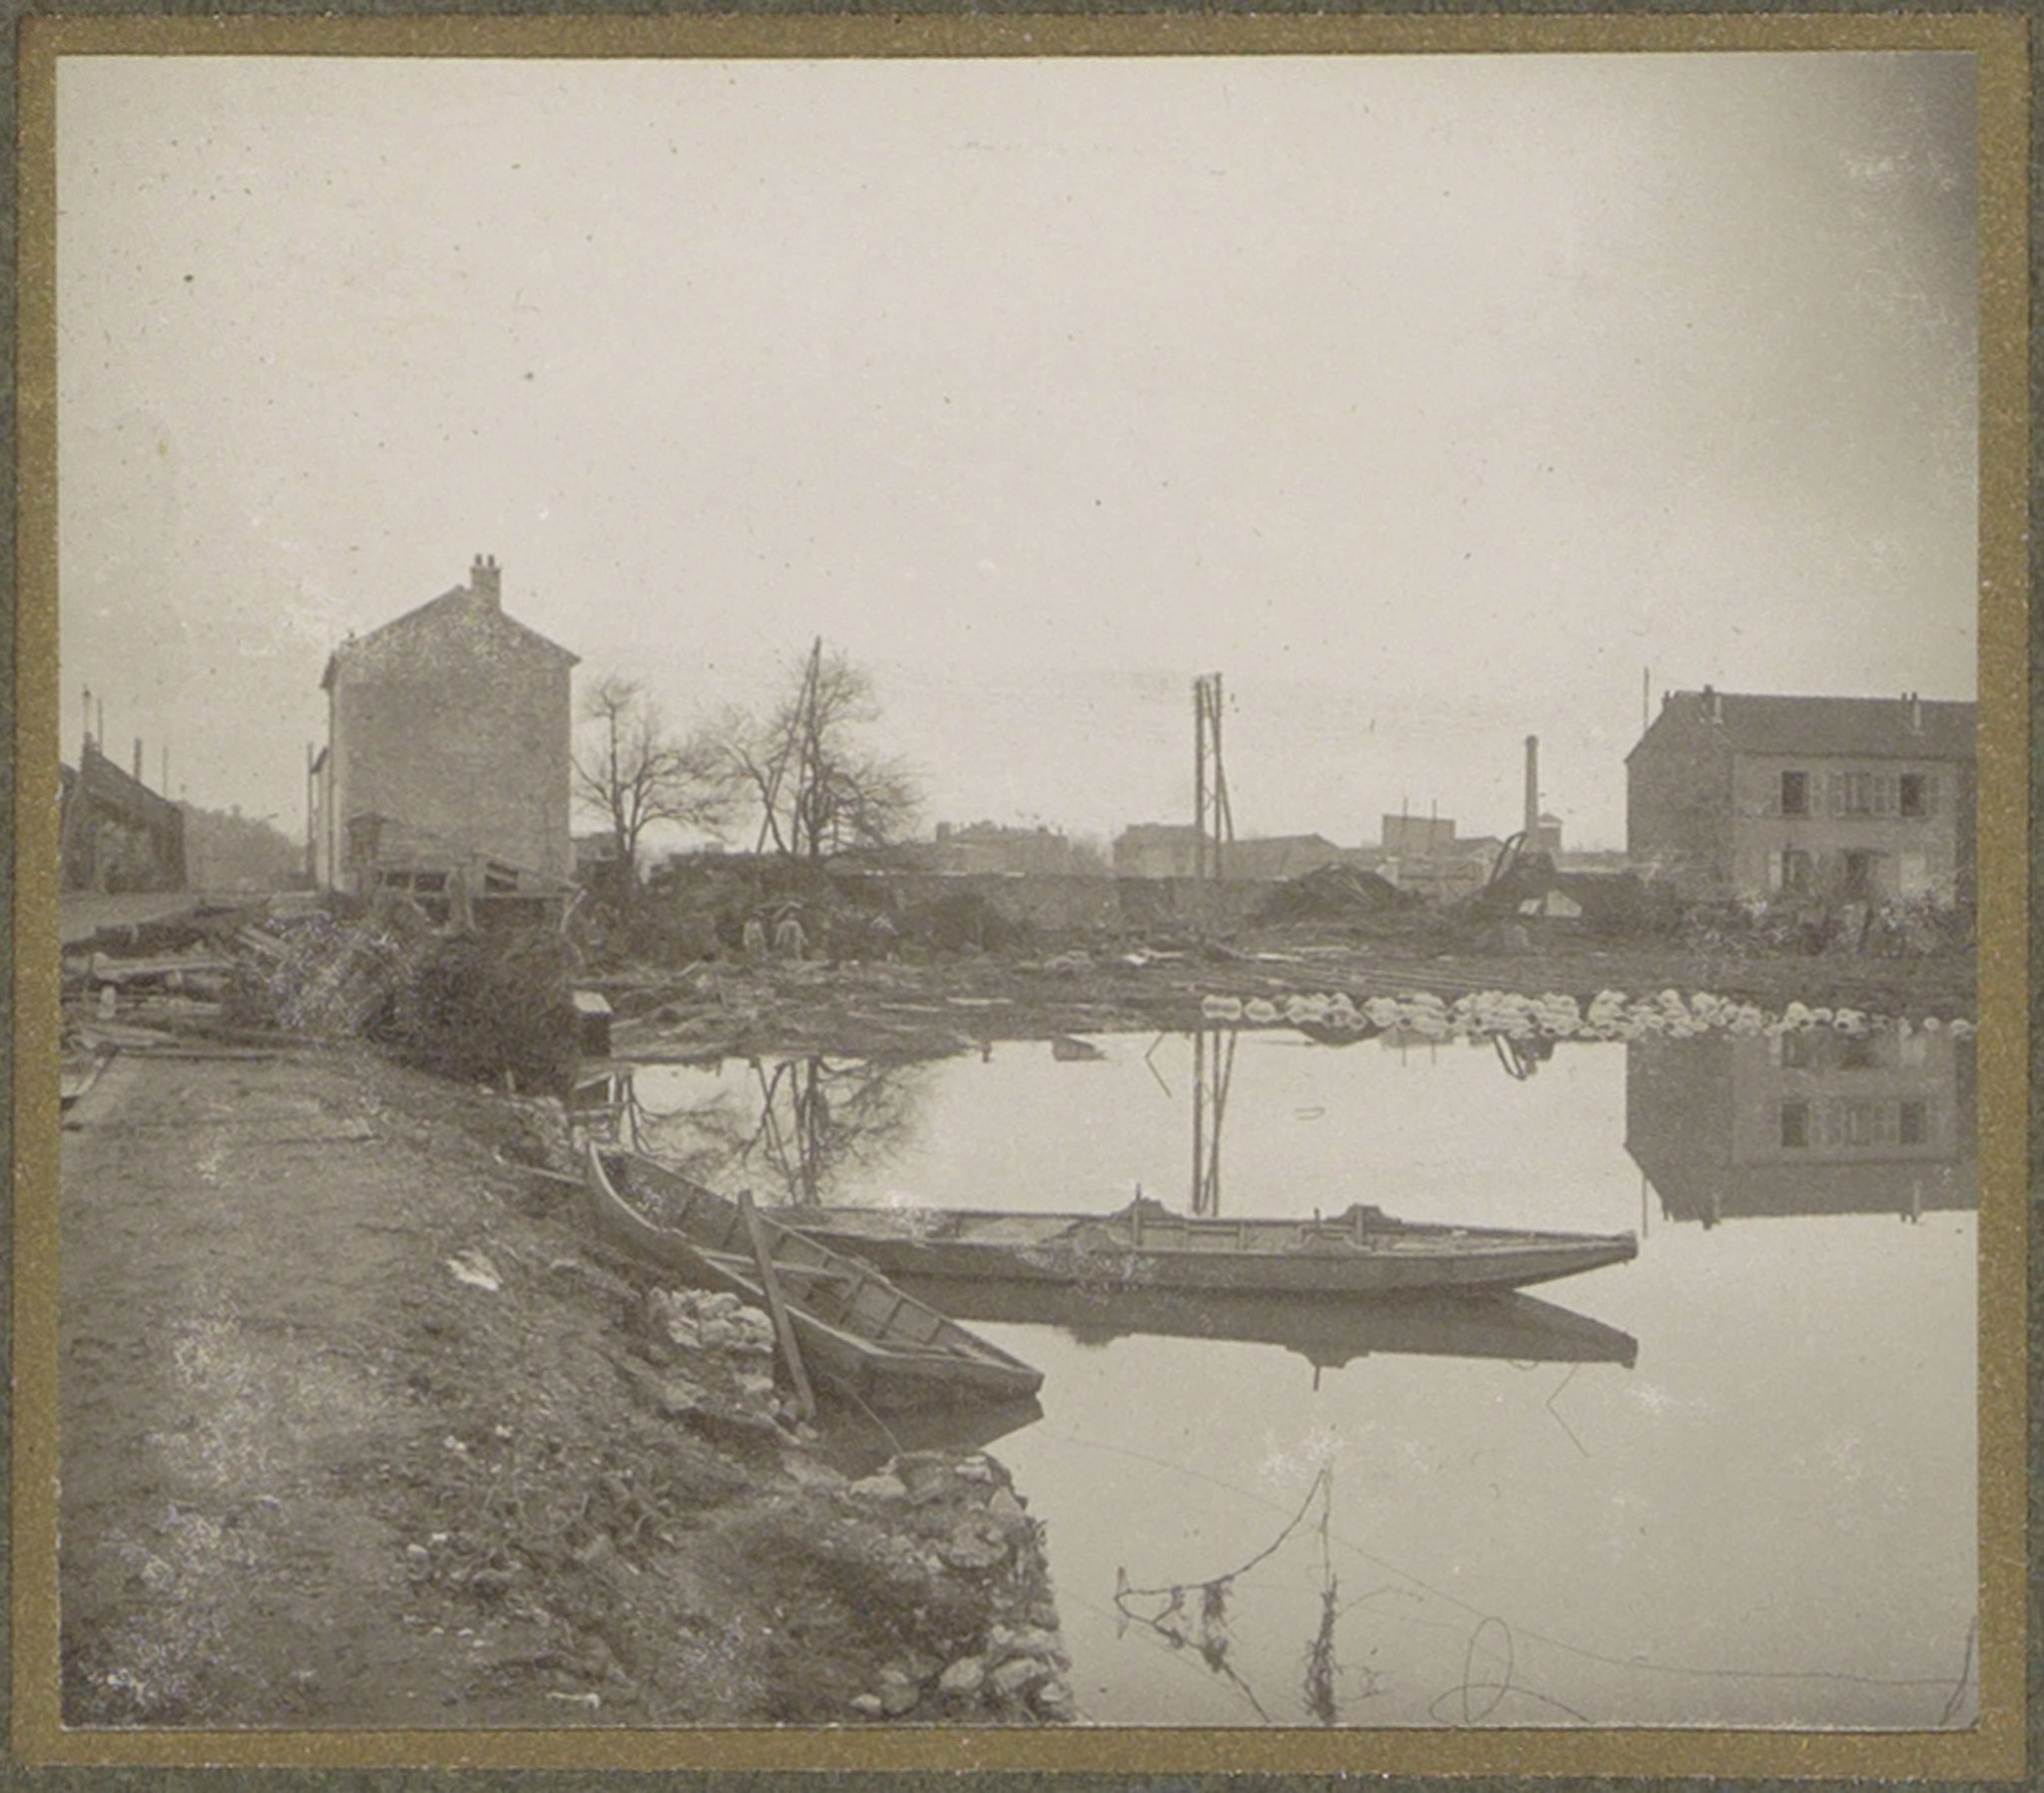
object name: photograph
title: Bootje en huizen in een overstroomde buitenwijk van Parijs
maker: g. dangereux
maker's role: fotograaf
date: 1901-1910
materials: photographic support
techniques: matte daylight collodion silver print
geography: paris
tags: flood (+ landscape with figures, staffage), rowing-boat, canoe, etc., paris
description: Onderdeel van fotoalbum overstroming Parijs en voorsteden 1910.